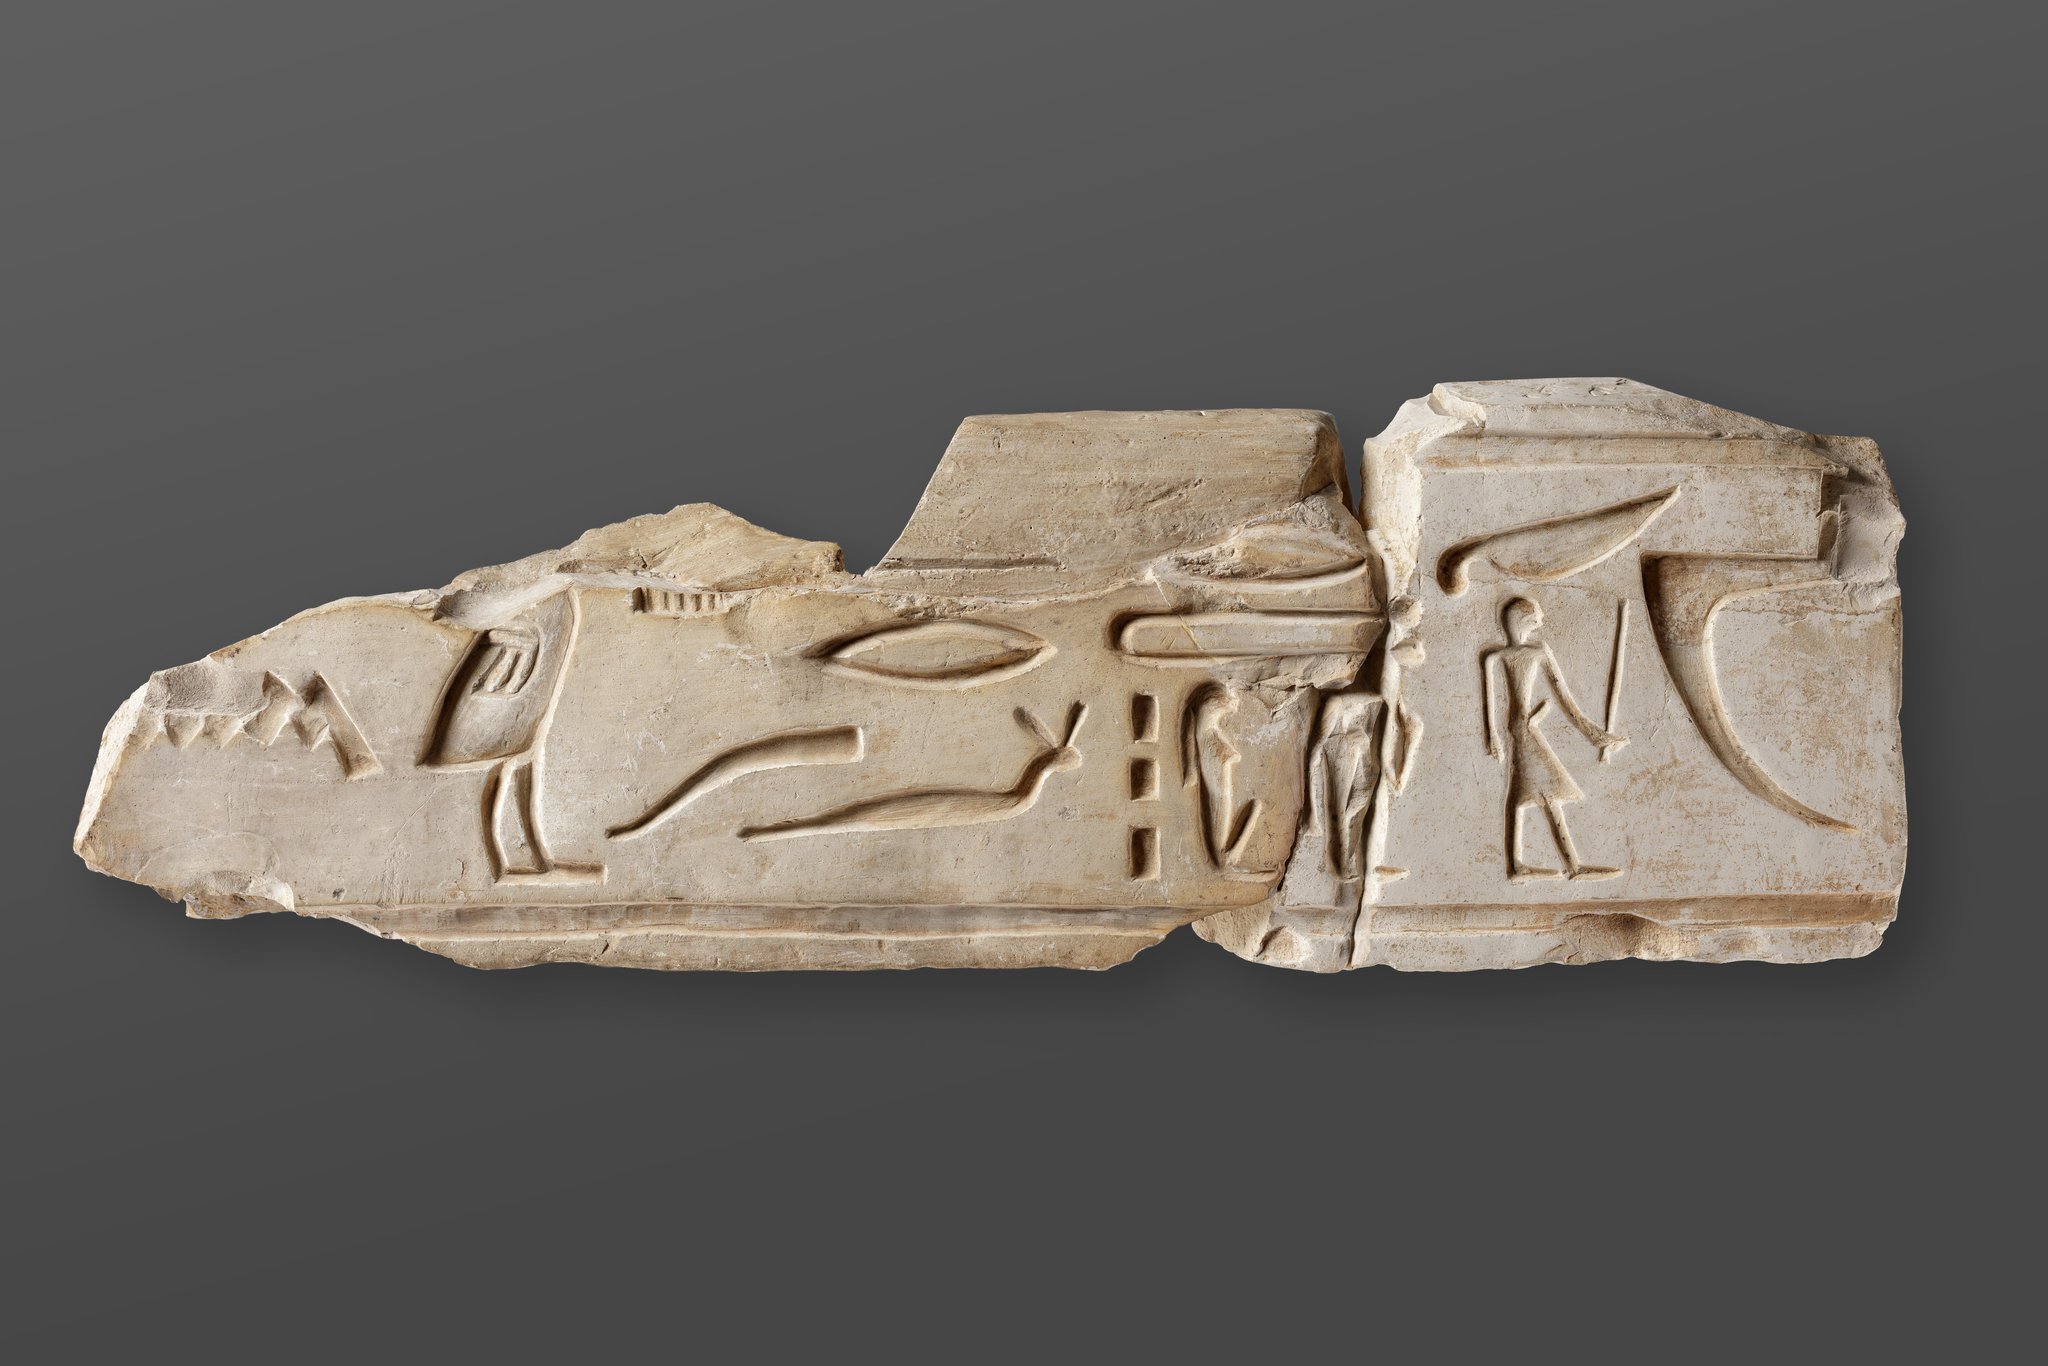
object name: relief fragment, tomb of mereri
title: Relief fragment from the tomb of Mereri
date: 2100-2030 BCE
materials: limestone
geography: egypt